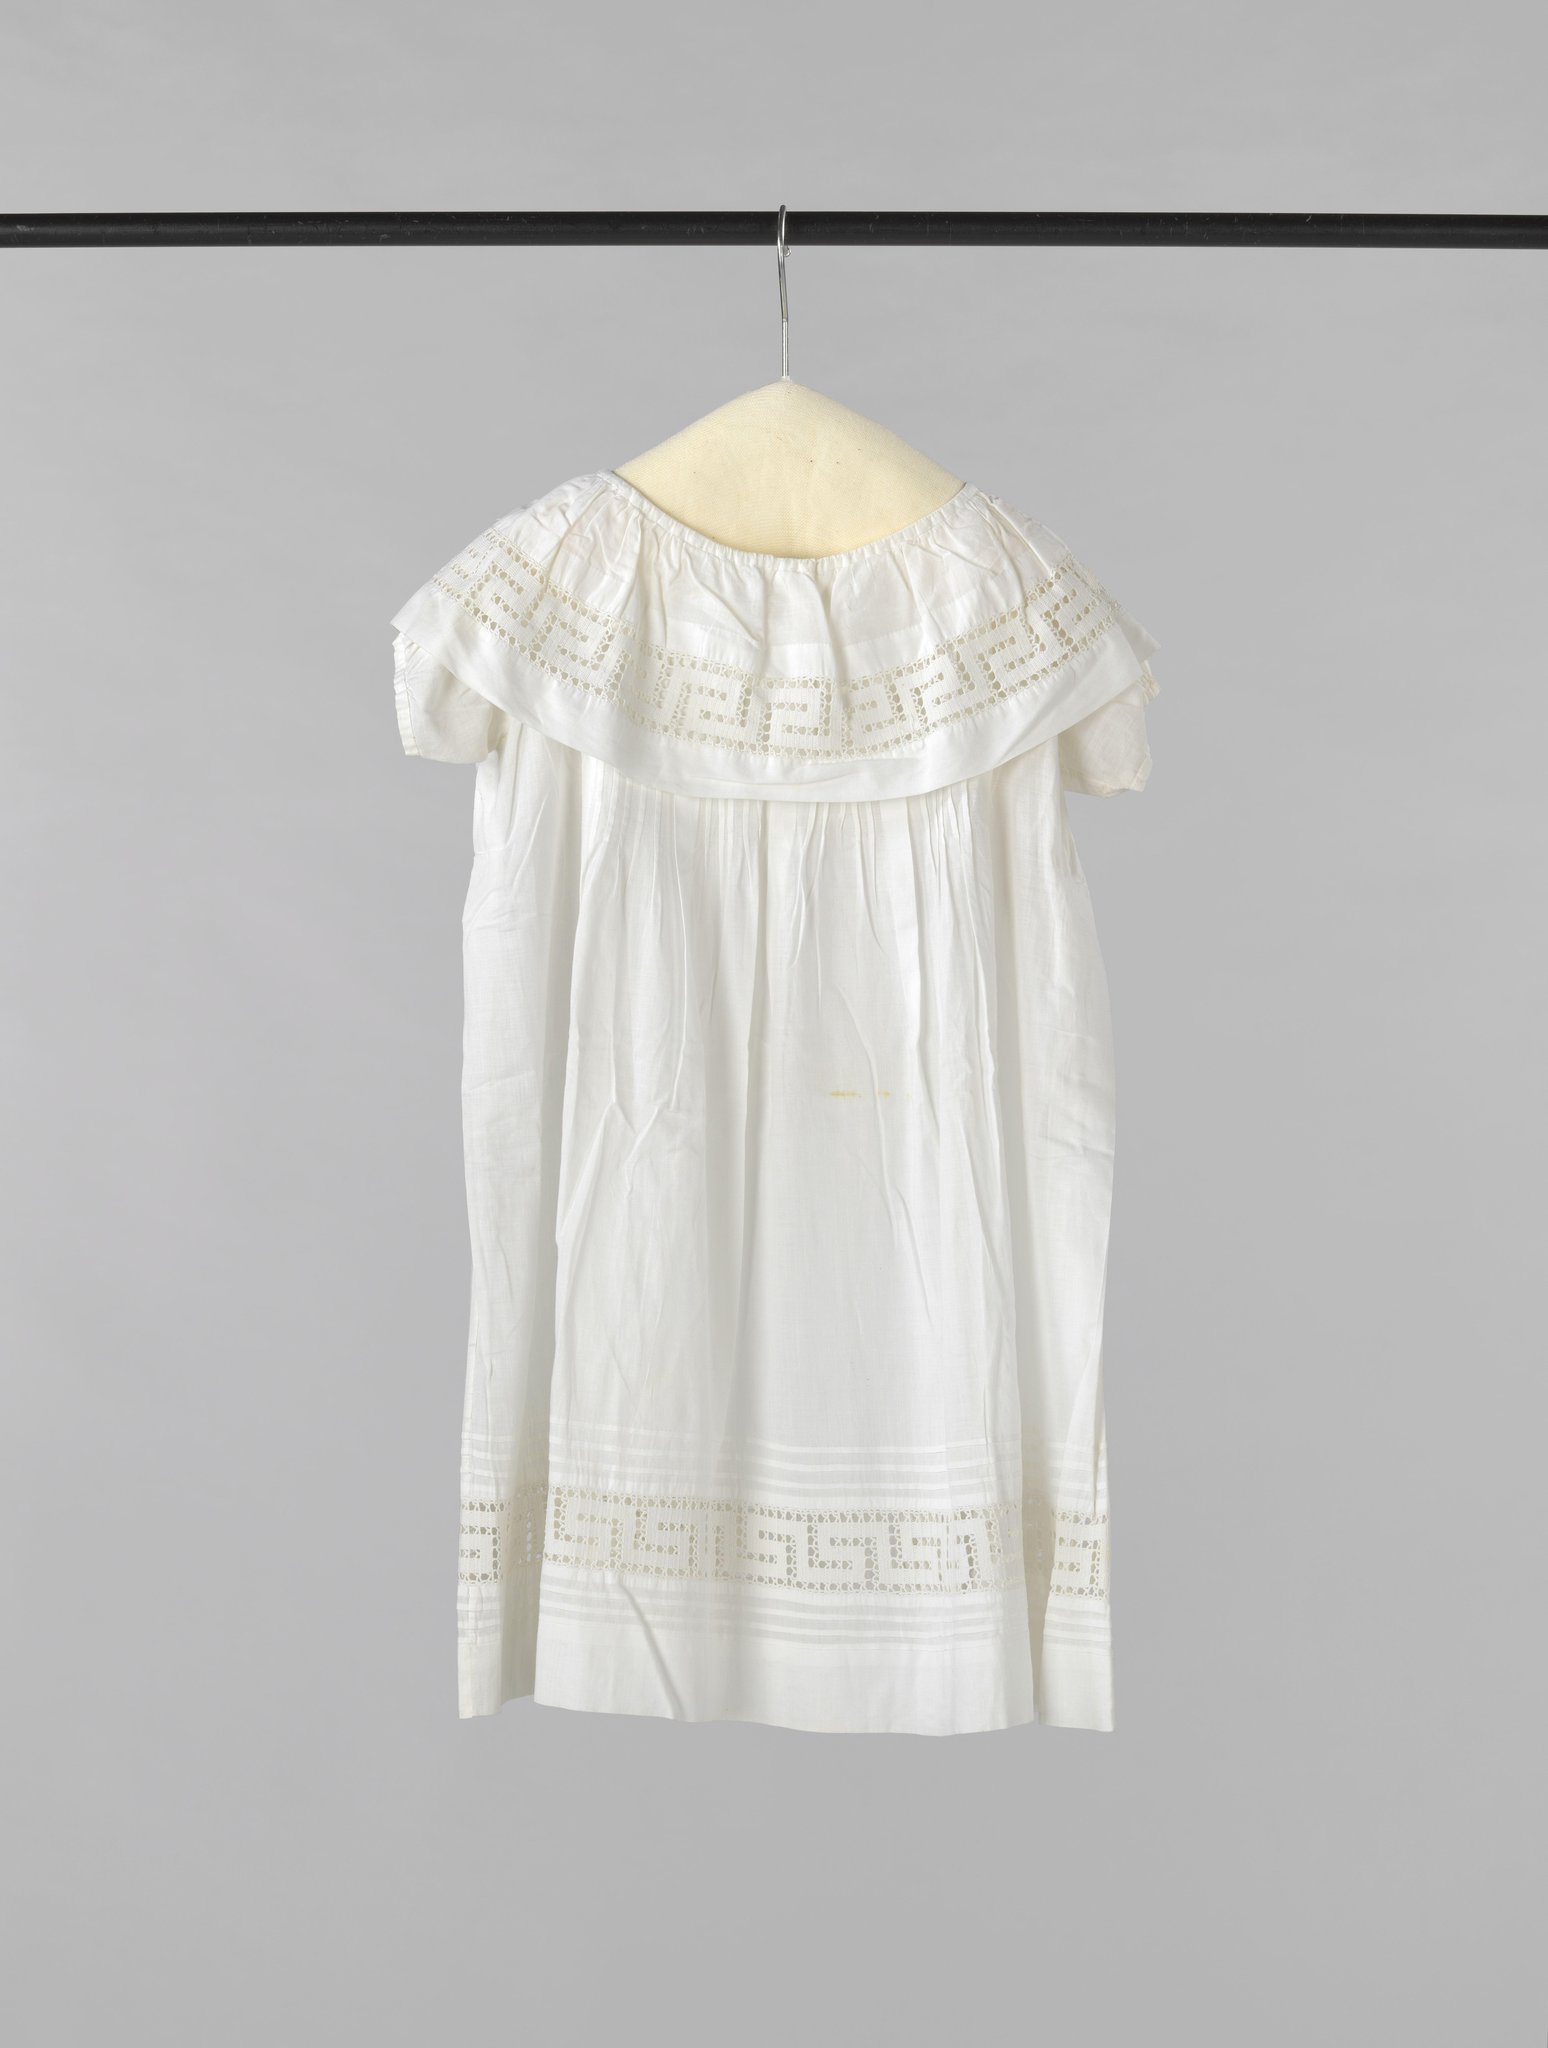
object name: kinderjurk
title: Effen witte kinderjurk met korte mouwen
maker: Anonymous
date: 1875-1925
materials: cotton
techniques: weave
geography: europe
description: Aan de achterzijde sluit de jurk met drie knopen. De jurk heeft een ronde kraag met een tussenzetsel en is aan de onderzijde voorzien van twee stroken met elk drie oprijgjes waartussen een tussenzetsel.